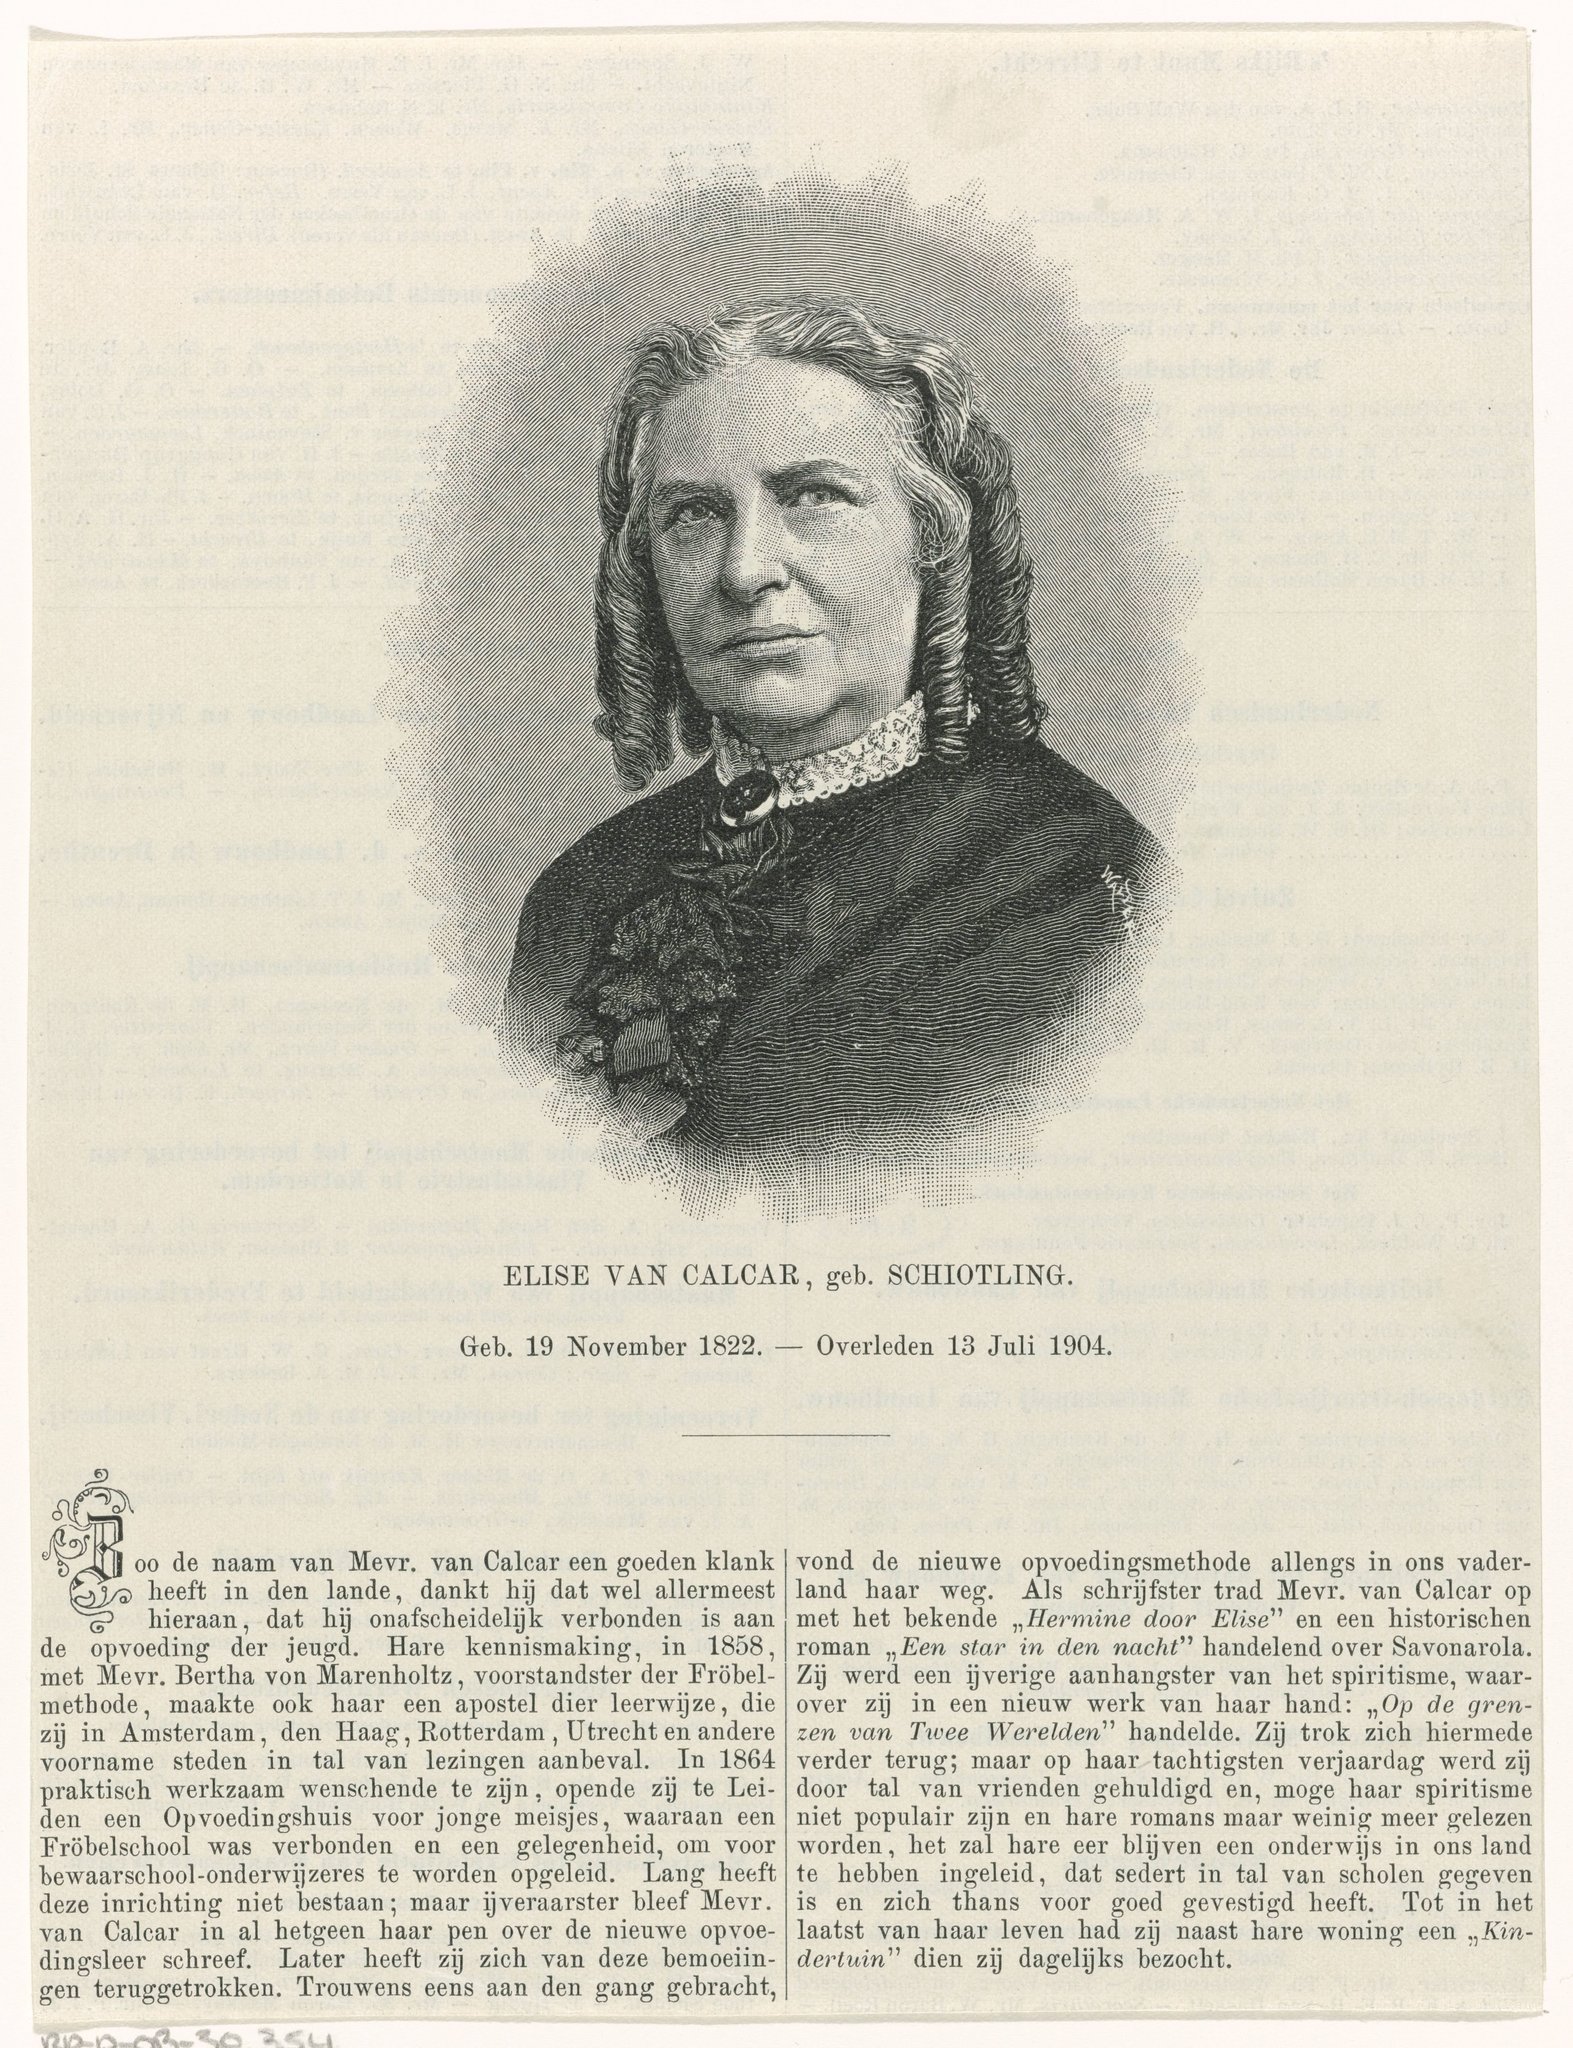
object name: book illustration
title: Portret van Elise van Calcar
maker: johannes walter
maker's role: print maker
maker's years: 1839-1895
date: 1904-1906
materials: paper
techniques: letterpress printing, engraving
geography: netherlands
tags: amsterdam, elise van calcar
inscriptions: collector's mark: Lugt 2228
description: Portret van Elise van Calcar. In de ondermarge haar naam, haar geboortedatum en haar sterfdatum.